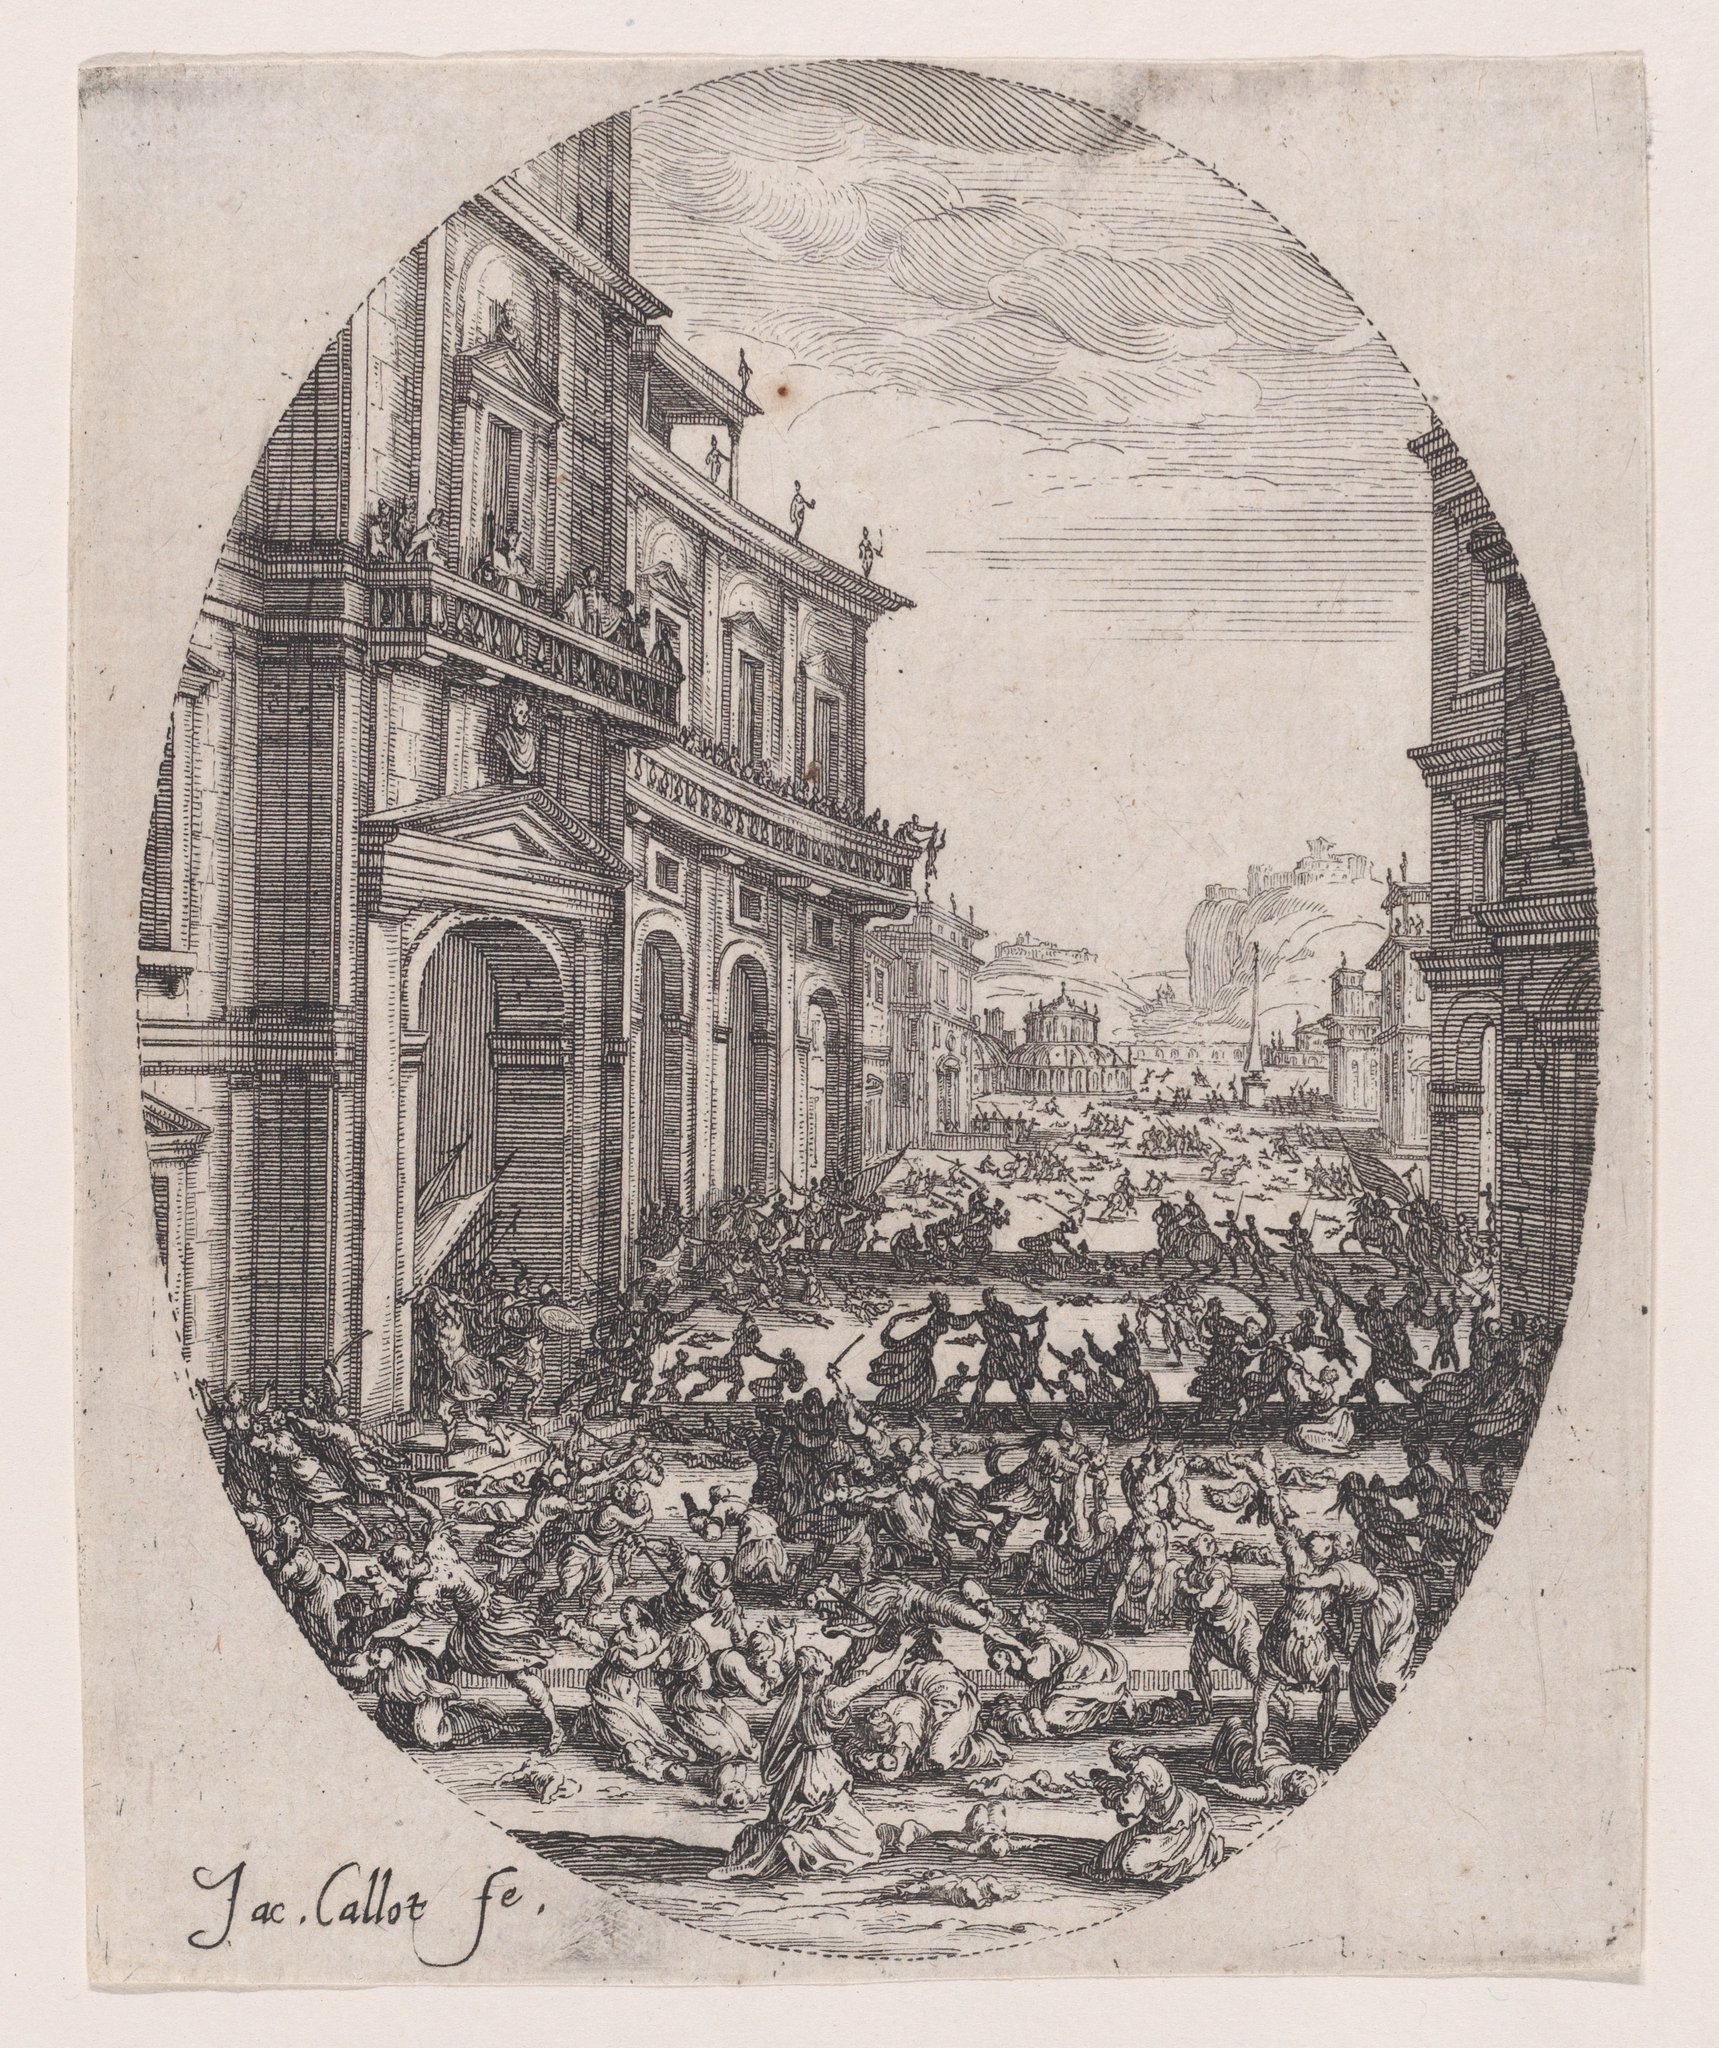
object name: print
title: Plate 2, from "Le Massacre des Innocents" (The Massacre of the Innocents)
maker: jacques callot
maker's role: artist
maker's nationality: french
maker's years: 1592-1635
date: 1621-1625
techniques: etching